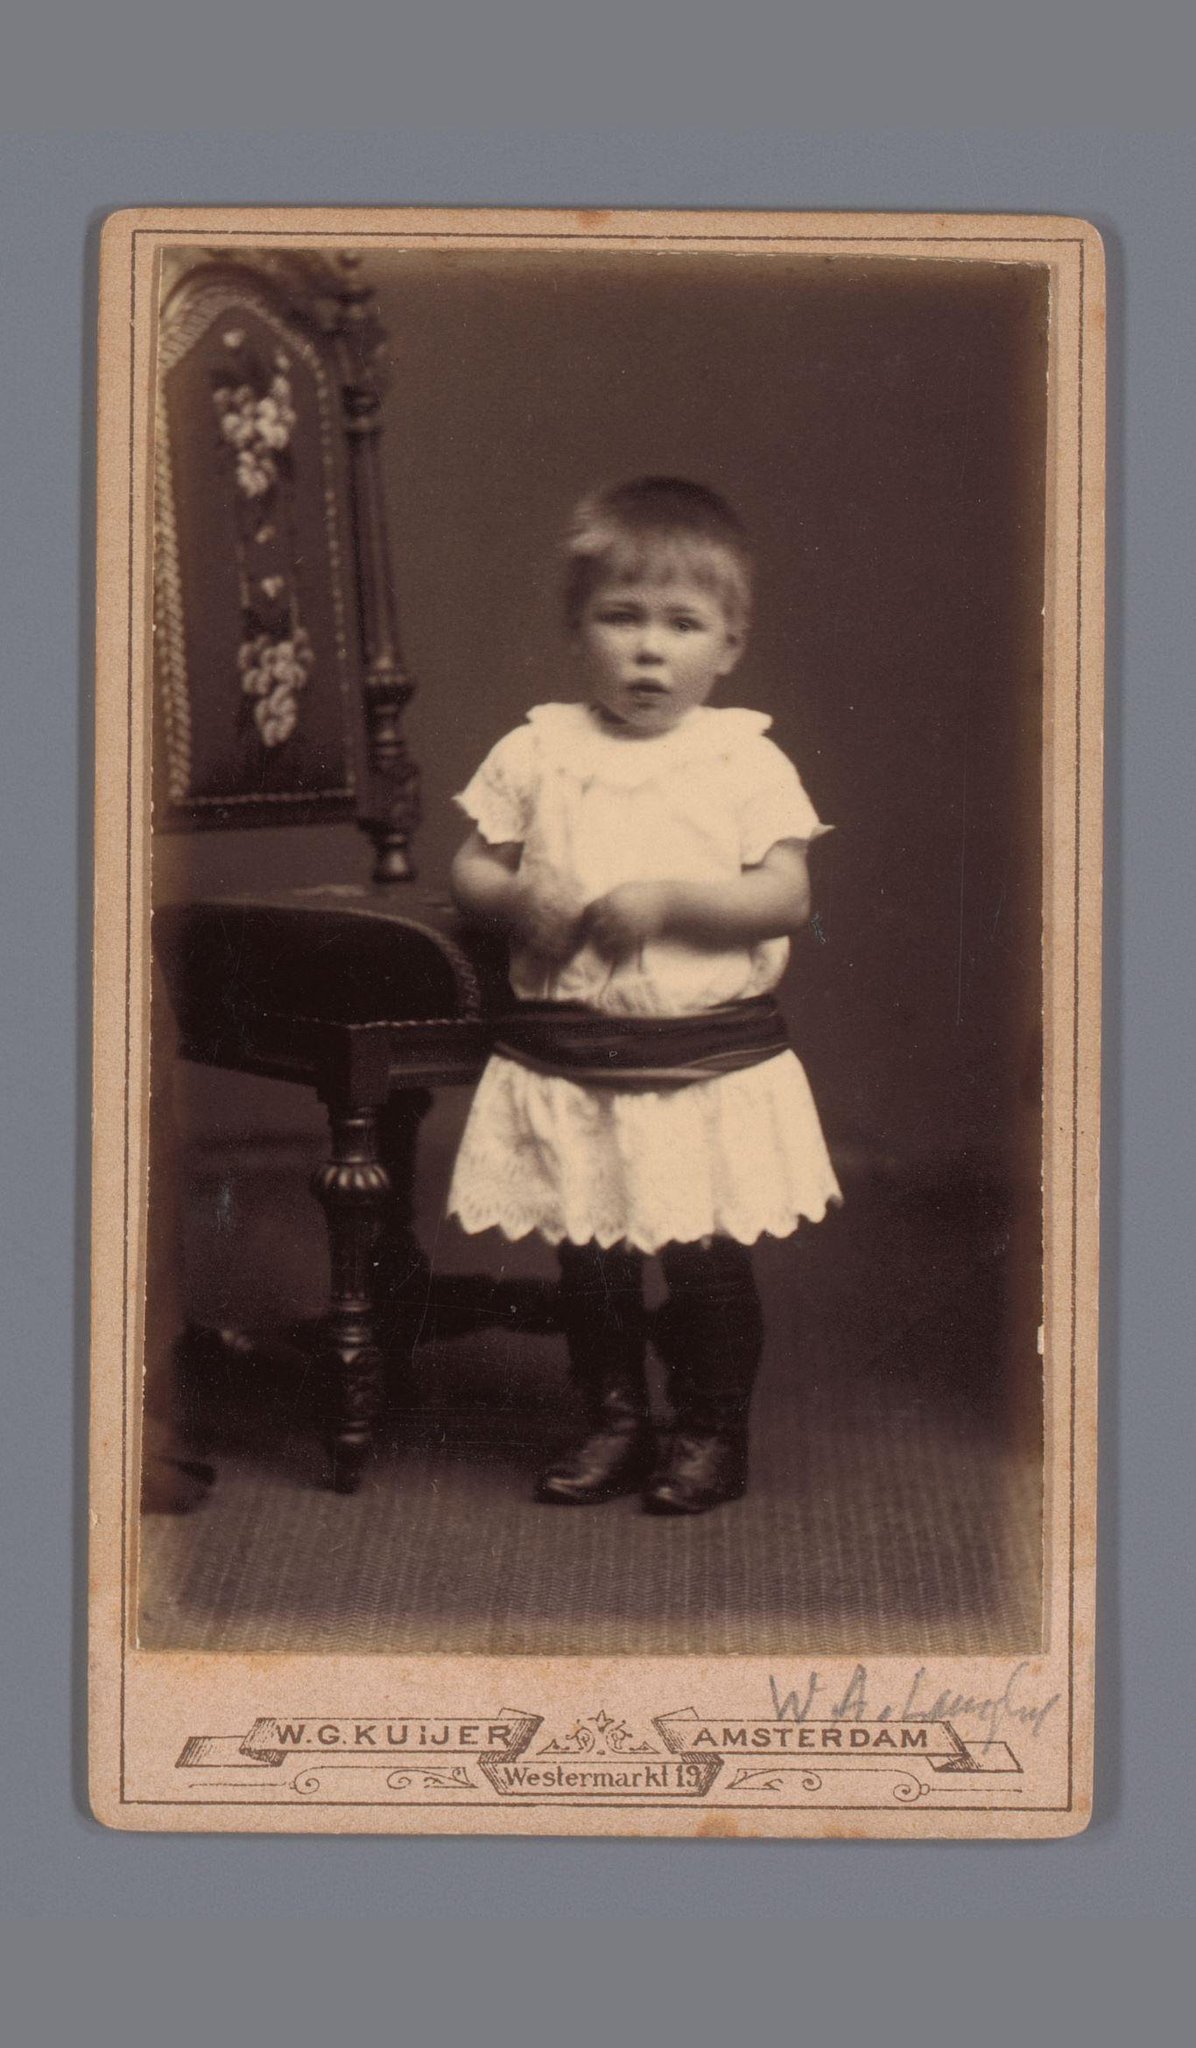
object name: carte de visite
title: Portret van een onbekend meisje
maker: willem gerhardus kuijer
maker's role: fotograaf, hoffotograaf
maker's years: 1834-1899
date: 1885-1906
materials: cardboard, photographic support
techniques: collodion silver print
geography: amsterdam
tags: historical persons - bb - woman, amsterdam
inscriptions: annotation: ‘W.A. Langhout’, workshop stamp: ‘Amsterdam/ W.G. Kuijer/ Westermarkt 19’, annotation: ‘Chr’